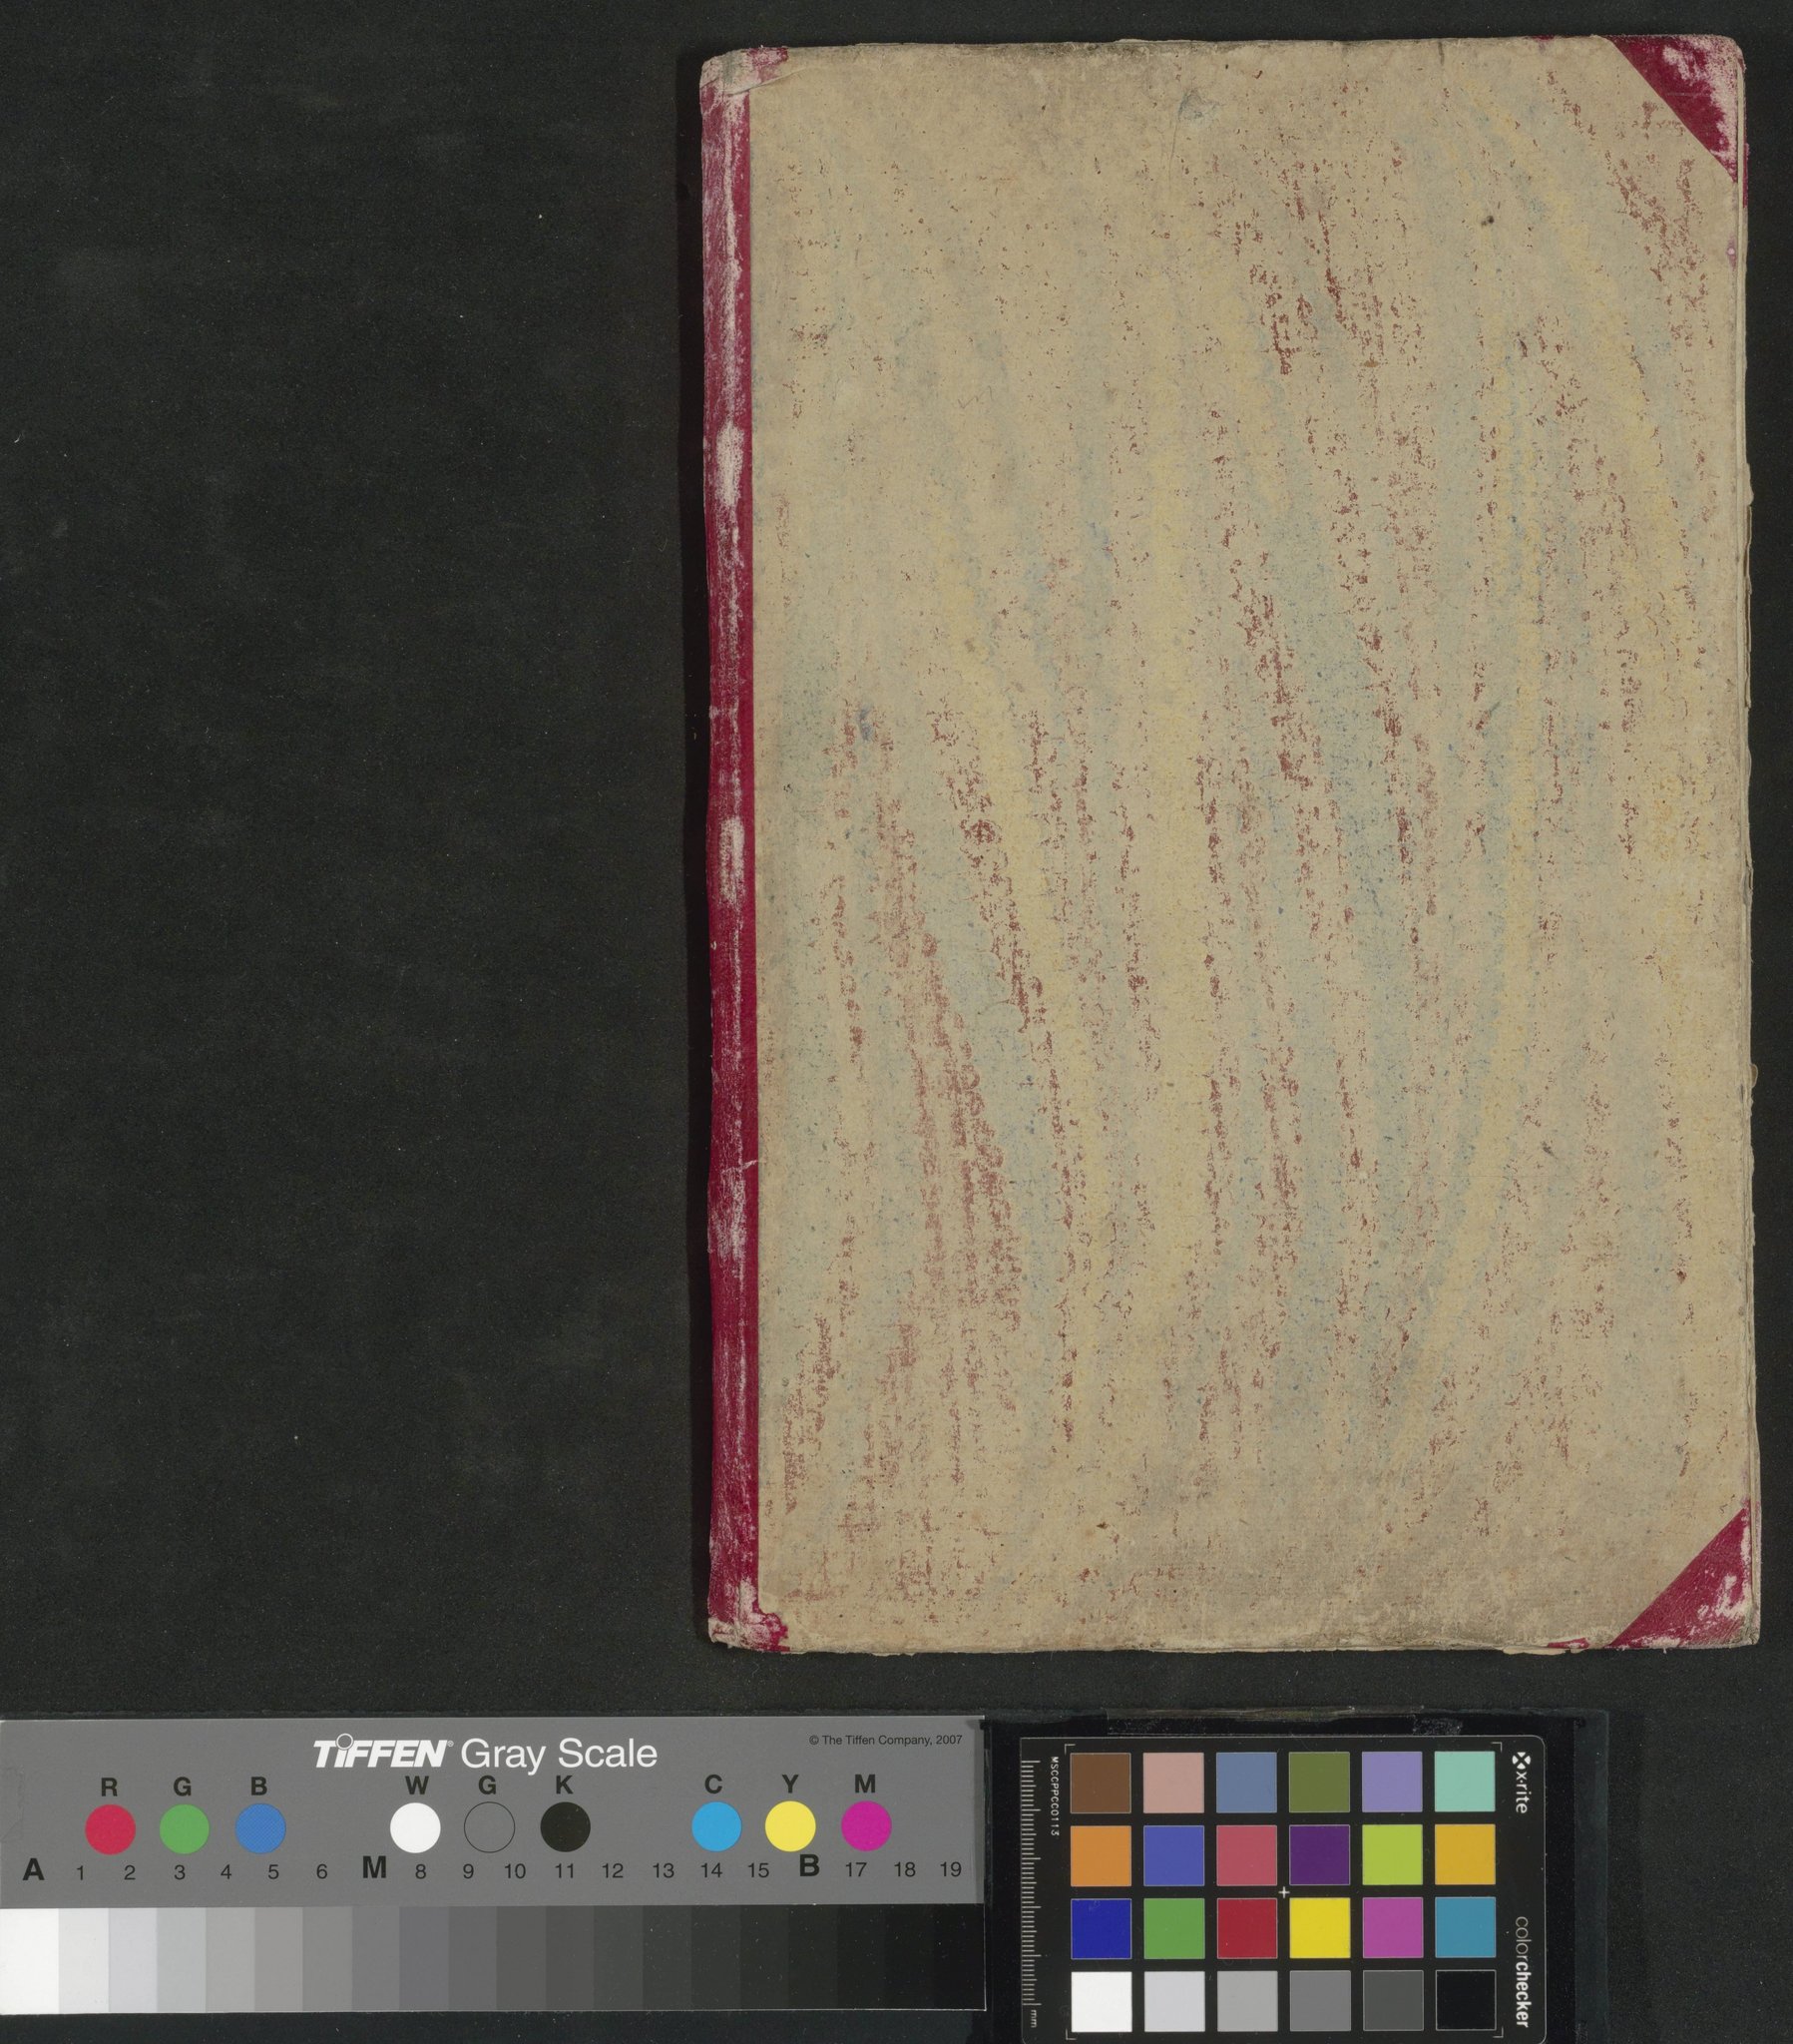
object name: sketchbook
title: Schetsboek met 25 bladen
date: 1780-1800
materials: cardboard, chalk, leather, paper, pencil, watercolor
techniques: brush, marbled paper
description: Het schetsboek is onregelmatig genummerd. Om deze reden is bij de invoer een nieuwe nummering per blad gehanteerd. De volgende bladen uit het schetsboek zijn blanco: 1(V) en 3(V), 7(V) t/m 20(V) en 22(V) t/m 24(V).